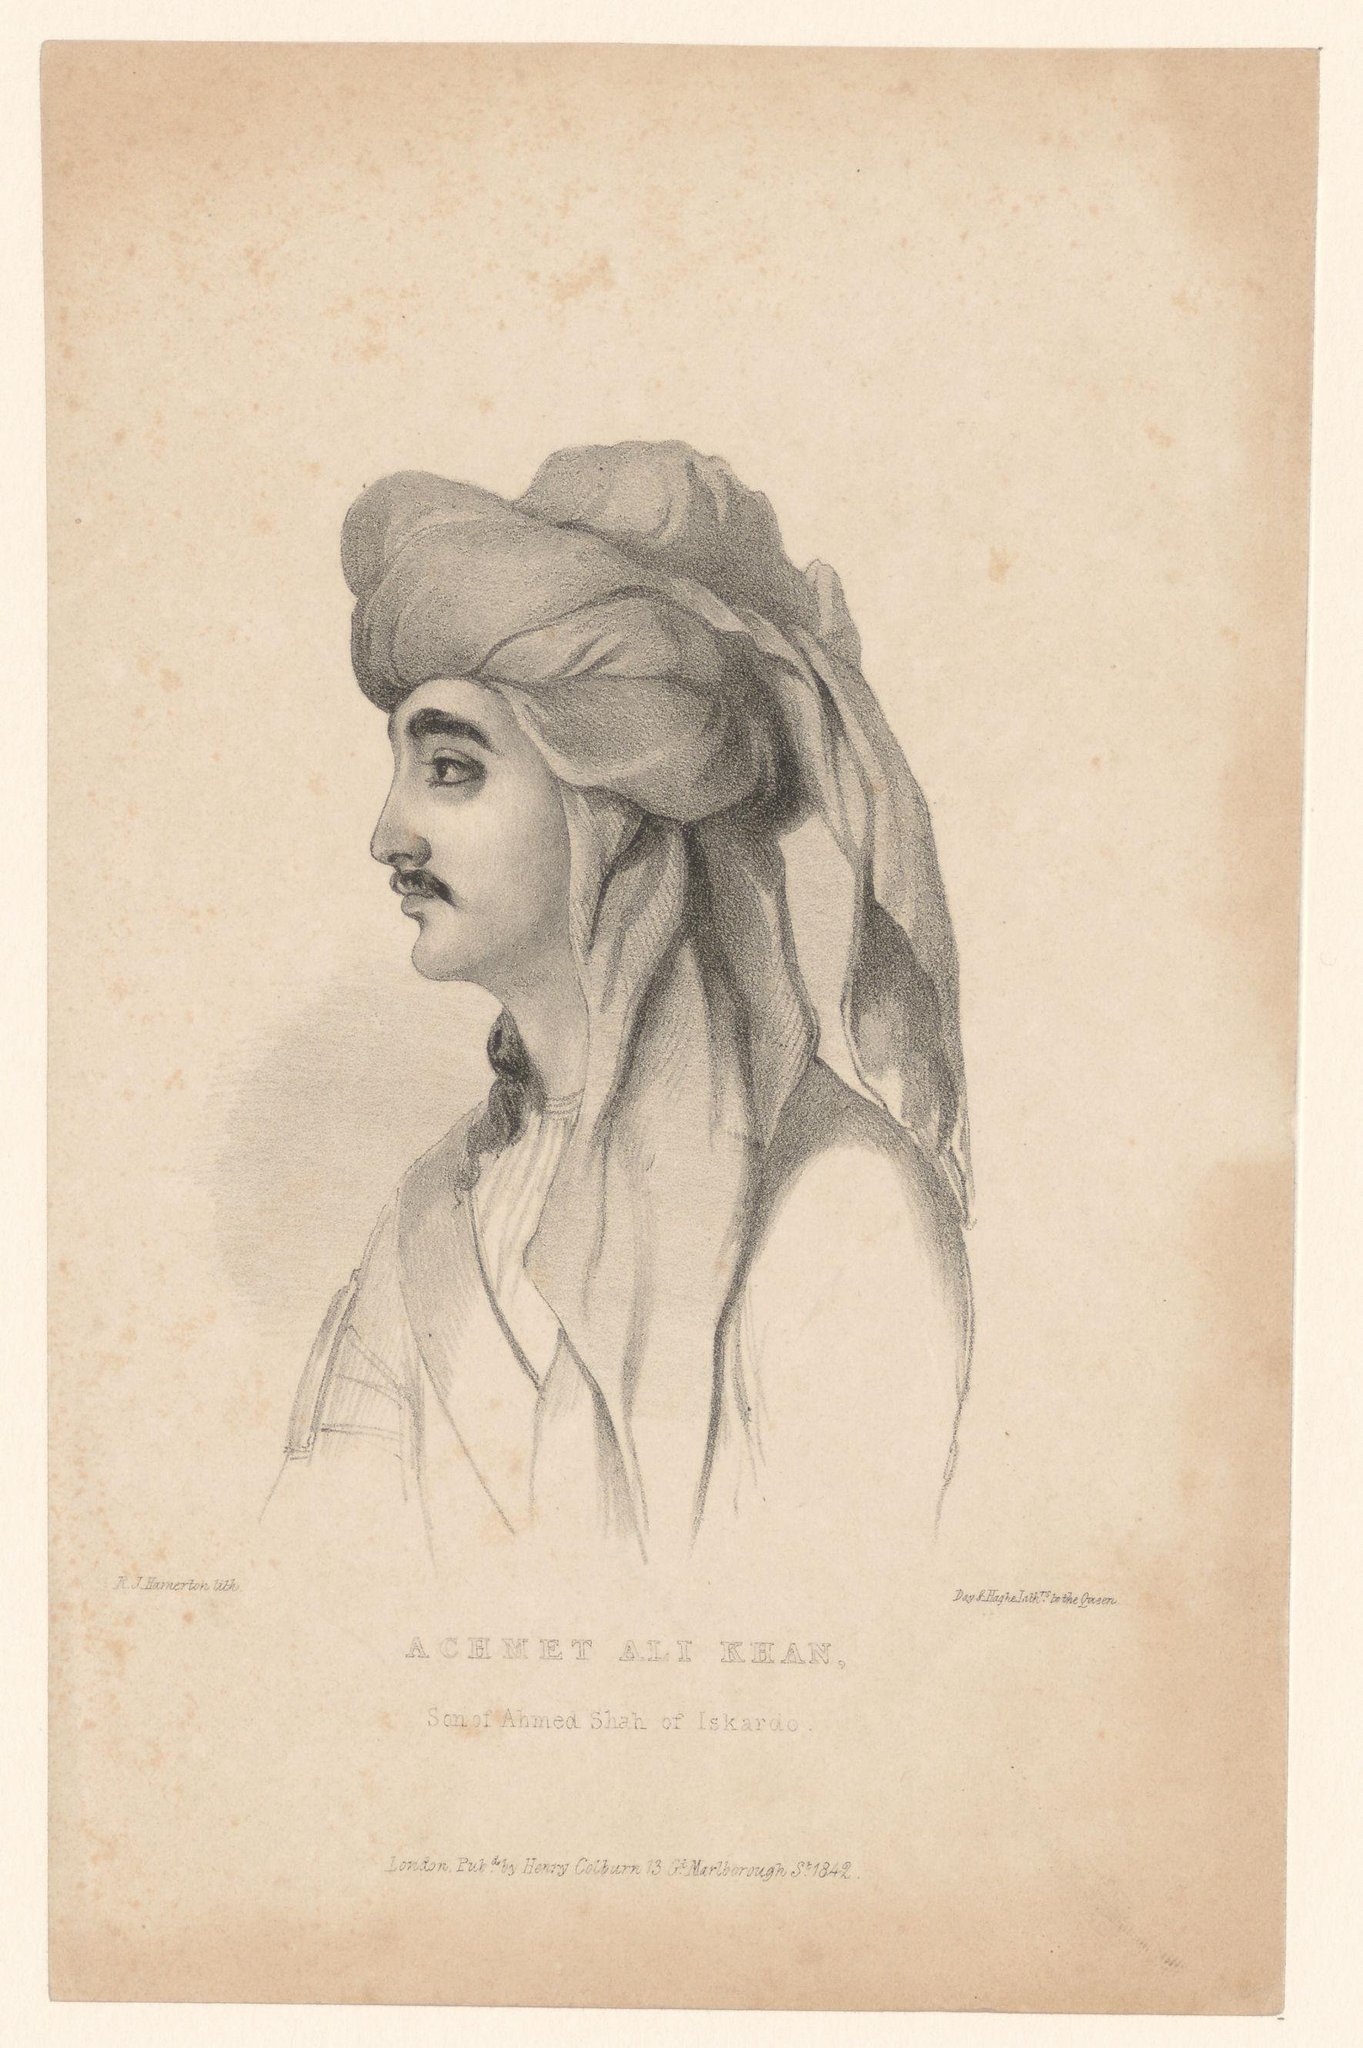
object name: print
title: Achmet Ali Khan, son of Ahmed Shah of Iskardo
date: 1842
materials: paper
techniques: lithograph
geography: london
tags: adult man, historical persons, head-gear: turban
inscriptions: collector's mark: Lugt 2228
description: Prent uit: Vigne, Godfrey Thomas. Travels in Kashmir, Ladak, Iskardo, the Countries Adjoining the Mountain-course of the Indus, and the Himalaya, north of the Panjab. Londen: Henry Colburn, 1842.